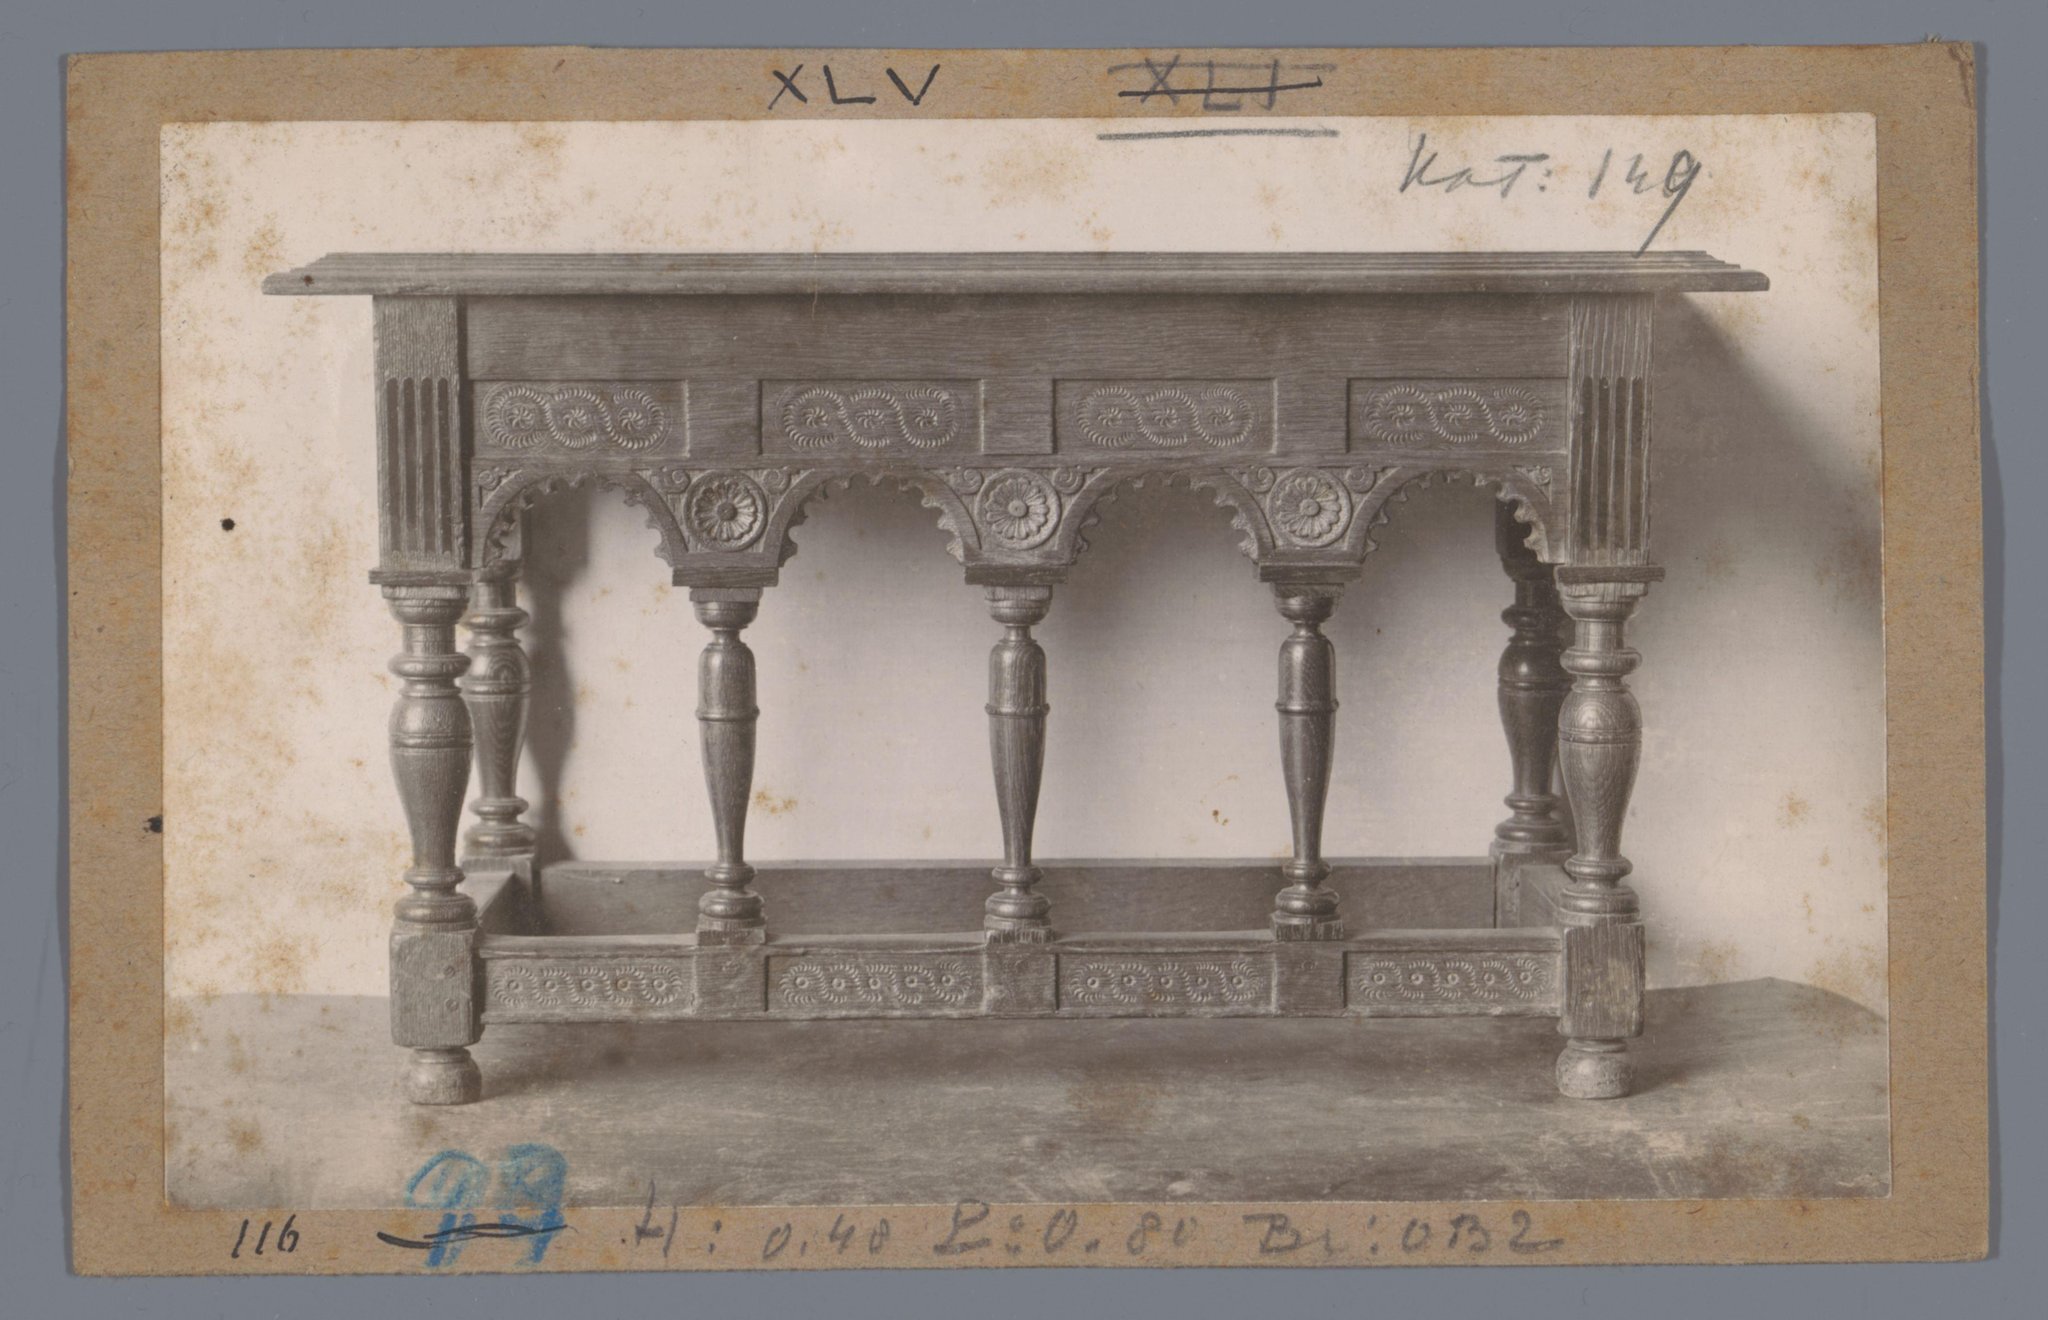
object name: photograph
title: Tafel gedecoreerd met bloemmotief (vermoedelijk) in het Rijksmuseum te Amsterdam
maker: Anonymous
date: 1875-1900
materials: photographic support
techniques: matte daylight collodion silver print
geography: amsterdam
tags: table, flowers ~ ornament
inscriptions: number: ‘XLV kat: 149 116’, collector's mark: ‘Kunstnijverheidschool Quellinus Amsterdam Frans Halsstraat 14.’, collector's mark: ‘Instituut voor kunst-nijverheidsonderwijs Gabriël Metsustraat No. 16, Amsterdam’